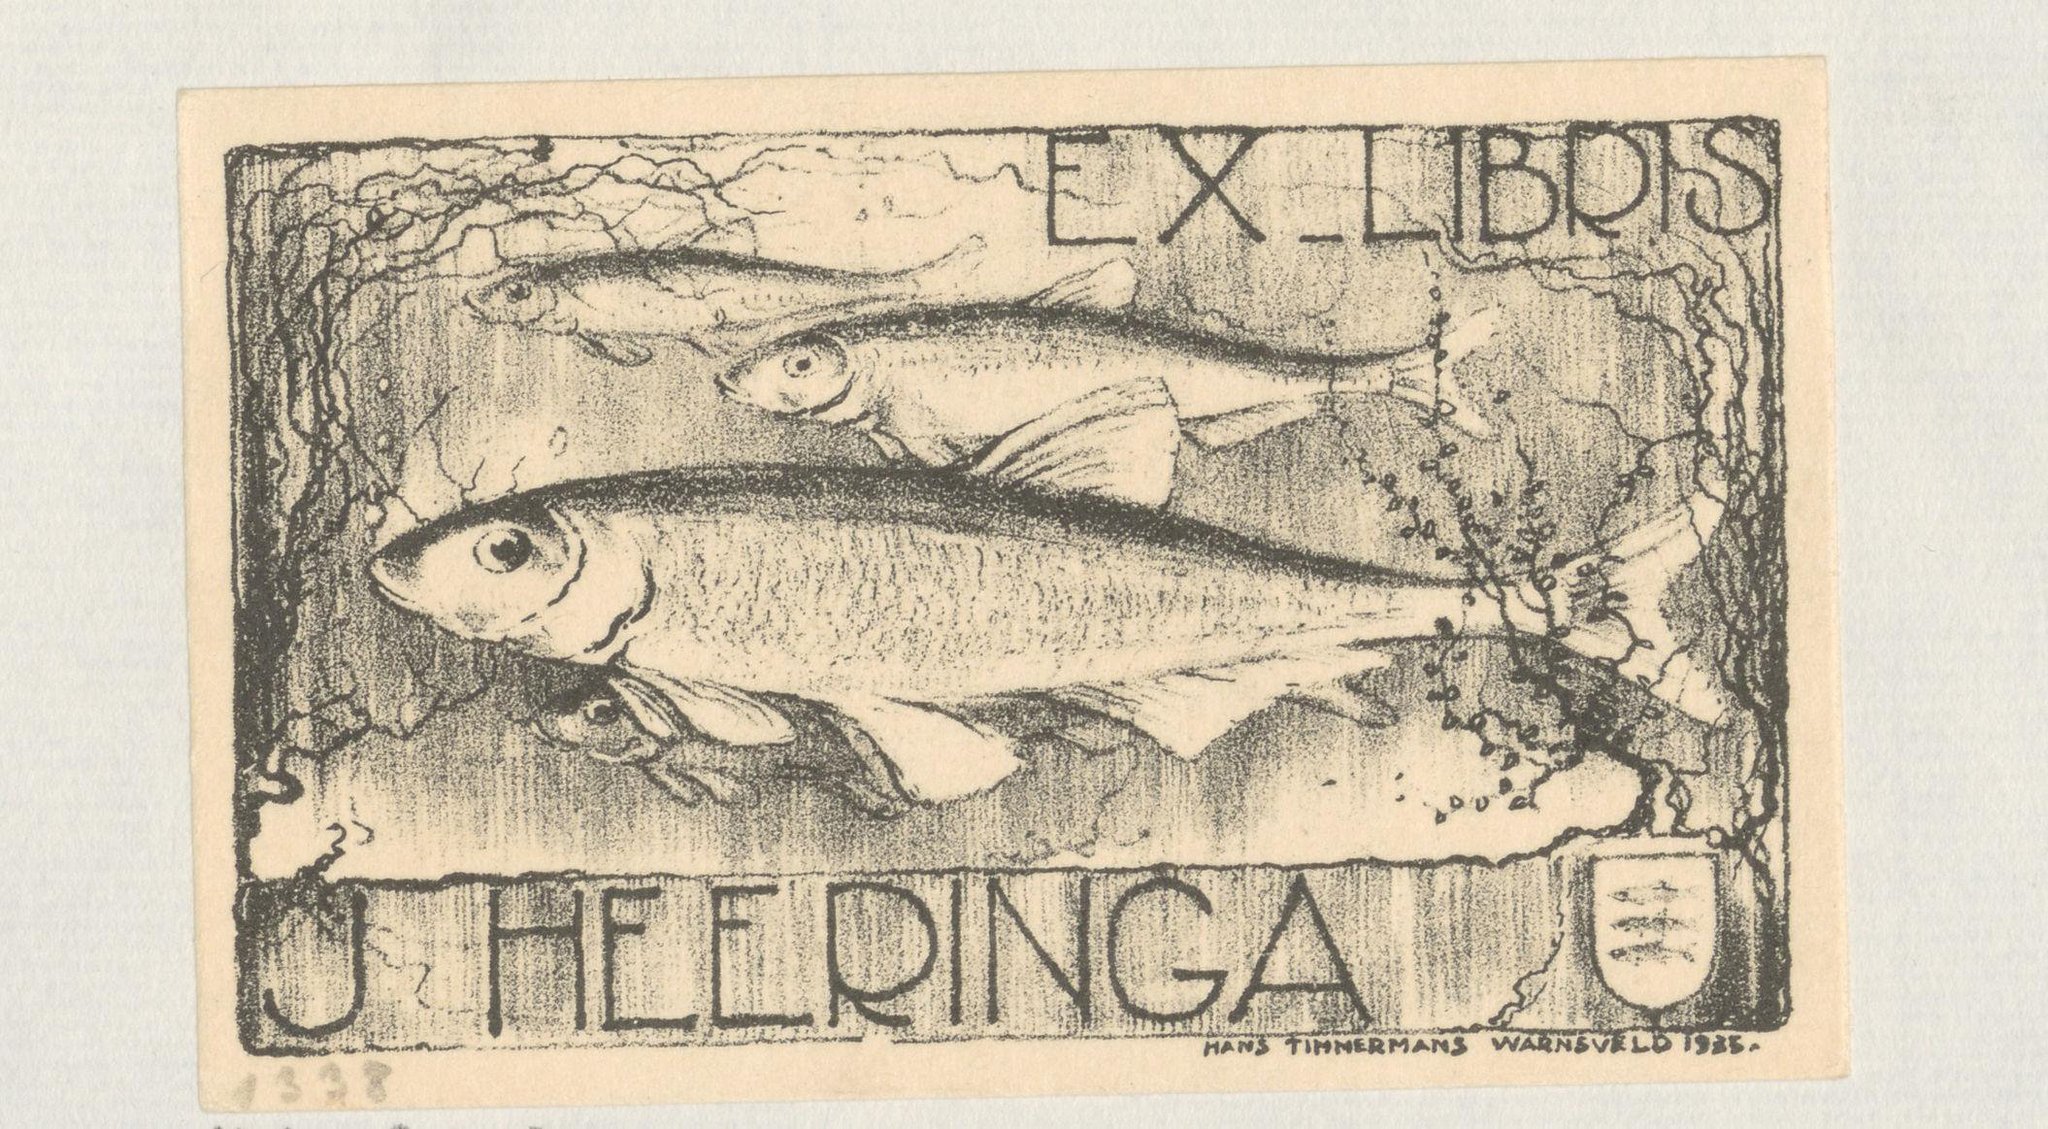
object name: bookplate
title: Ex libris van J. Heeringa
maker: hans timmermans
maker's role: painter, print maker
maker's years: 1900-1943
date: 1935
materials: paper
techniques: lithograph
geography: warnsveld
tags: aquarium, fishes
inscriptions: inscription: ‘1338’